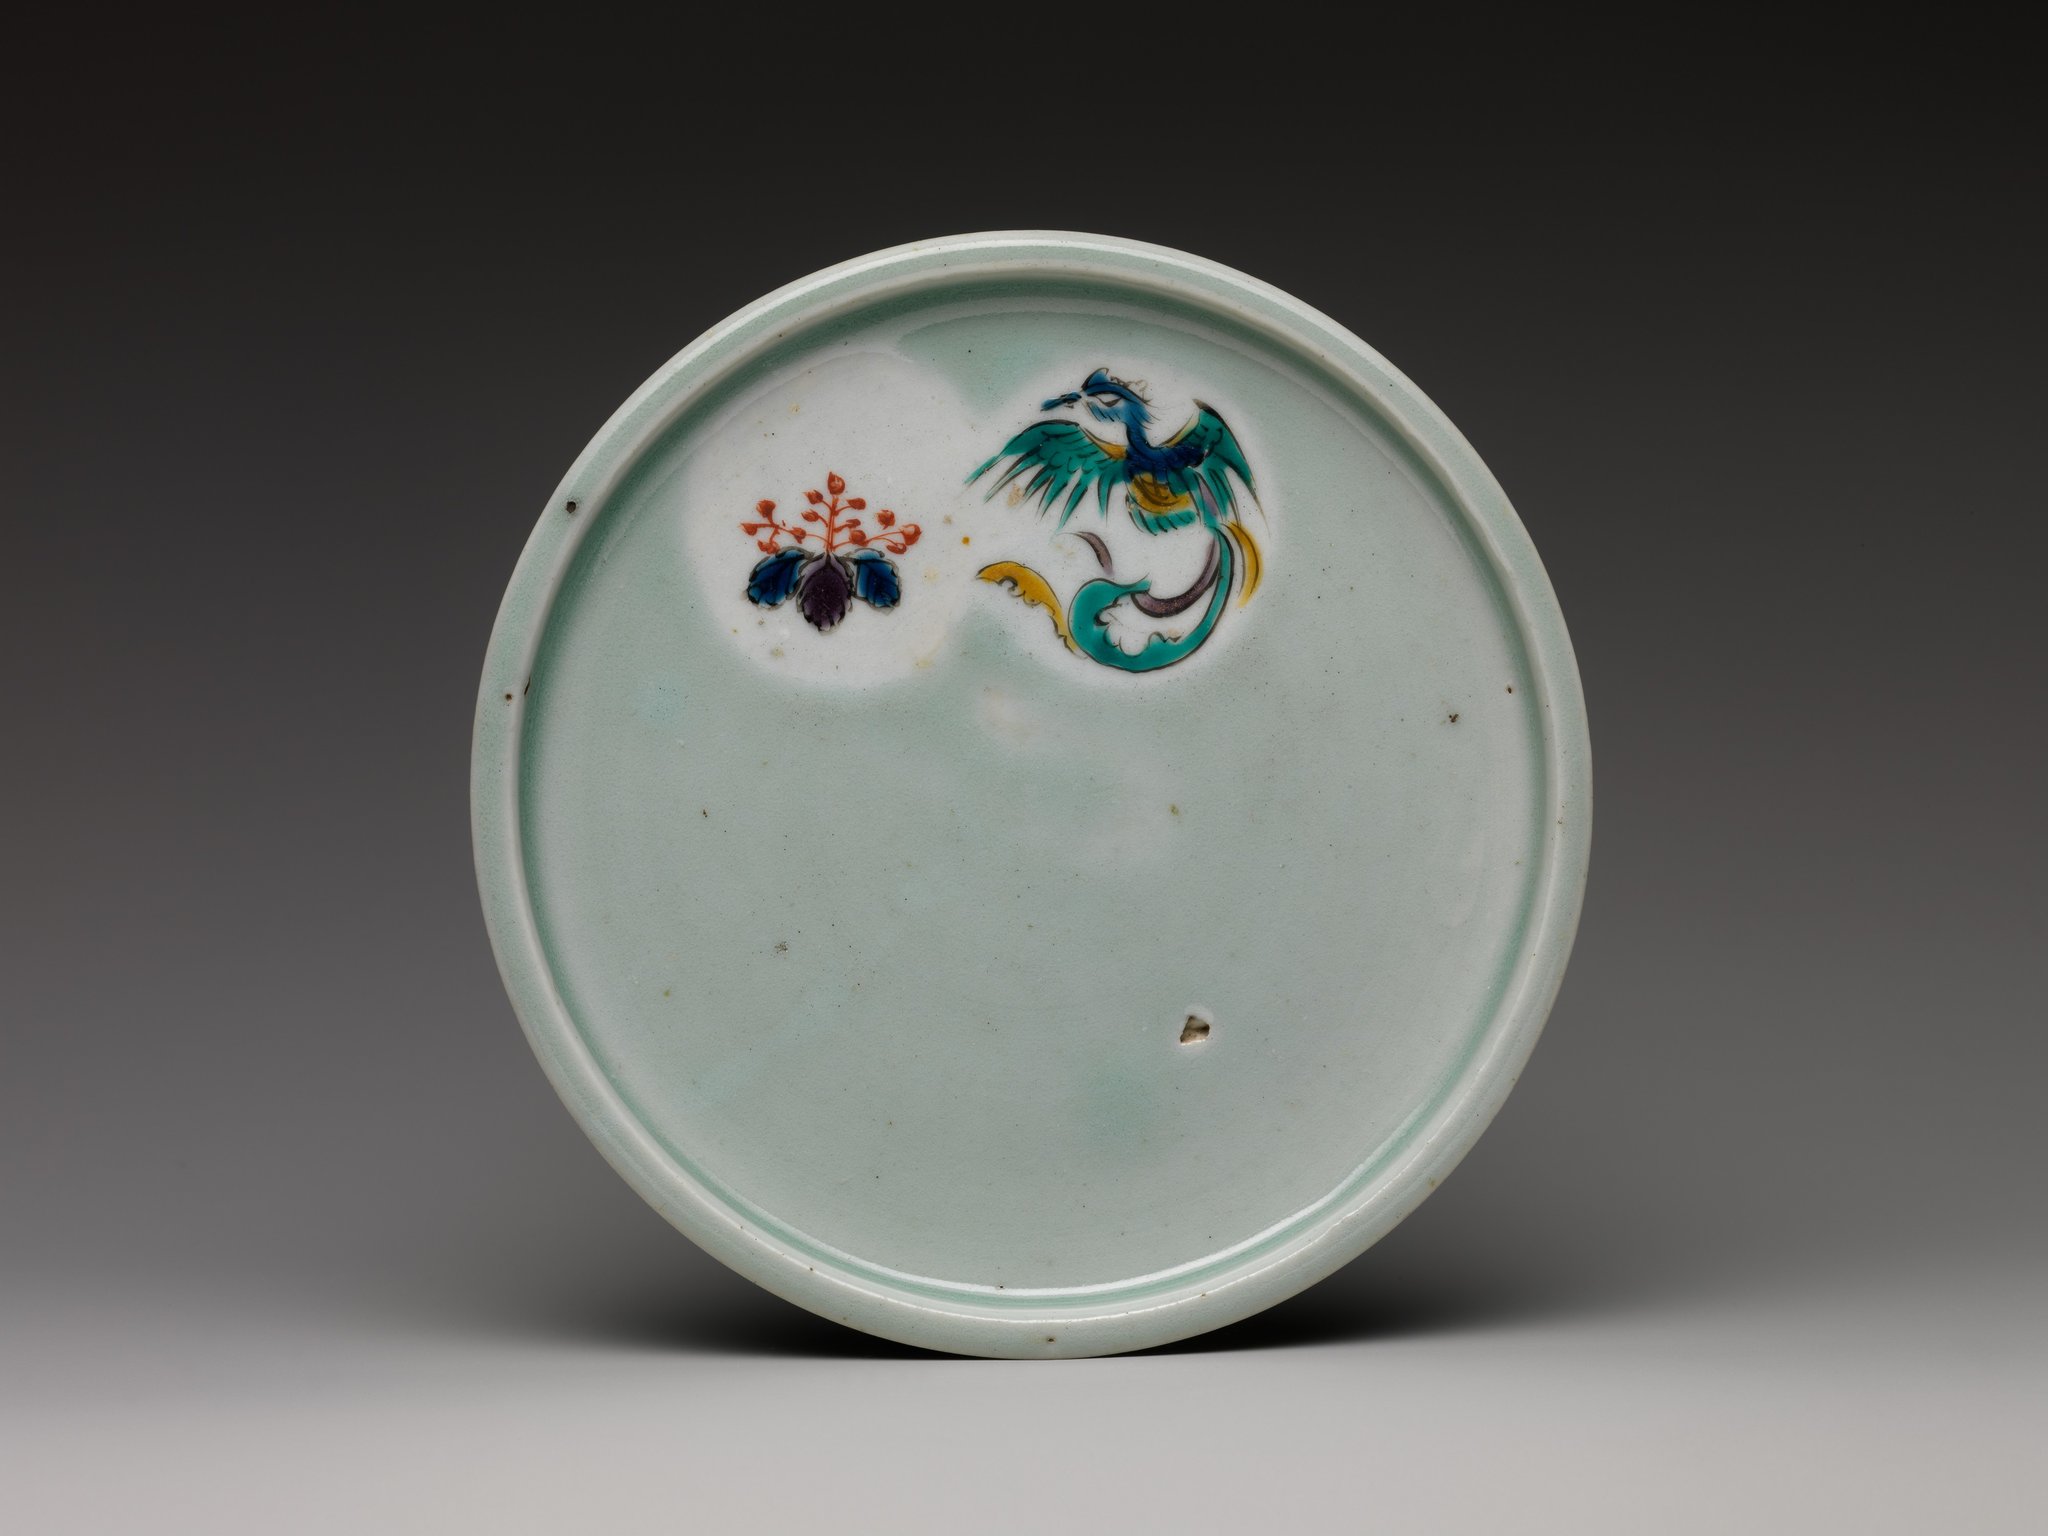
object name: dish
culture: japanese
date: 1615-1868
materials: ceramic glaze, enamel, glaze, porcelain